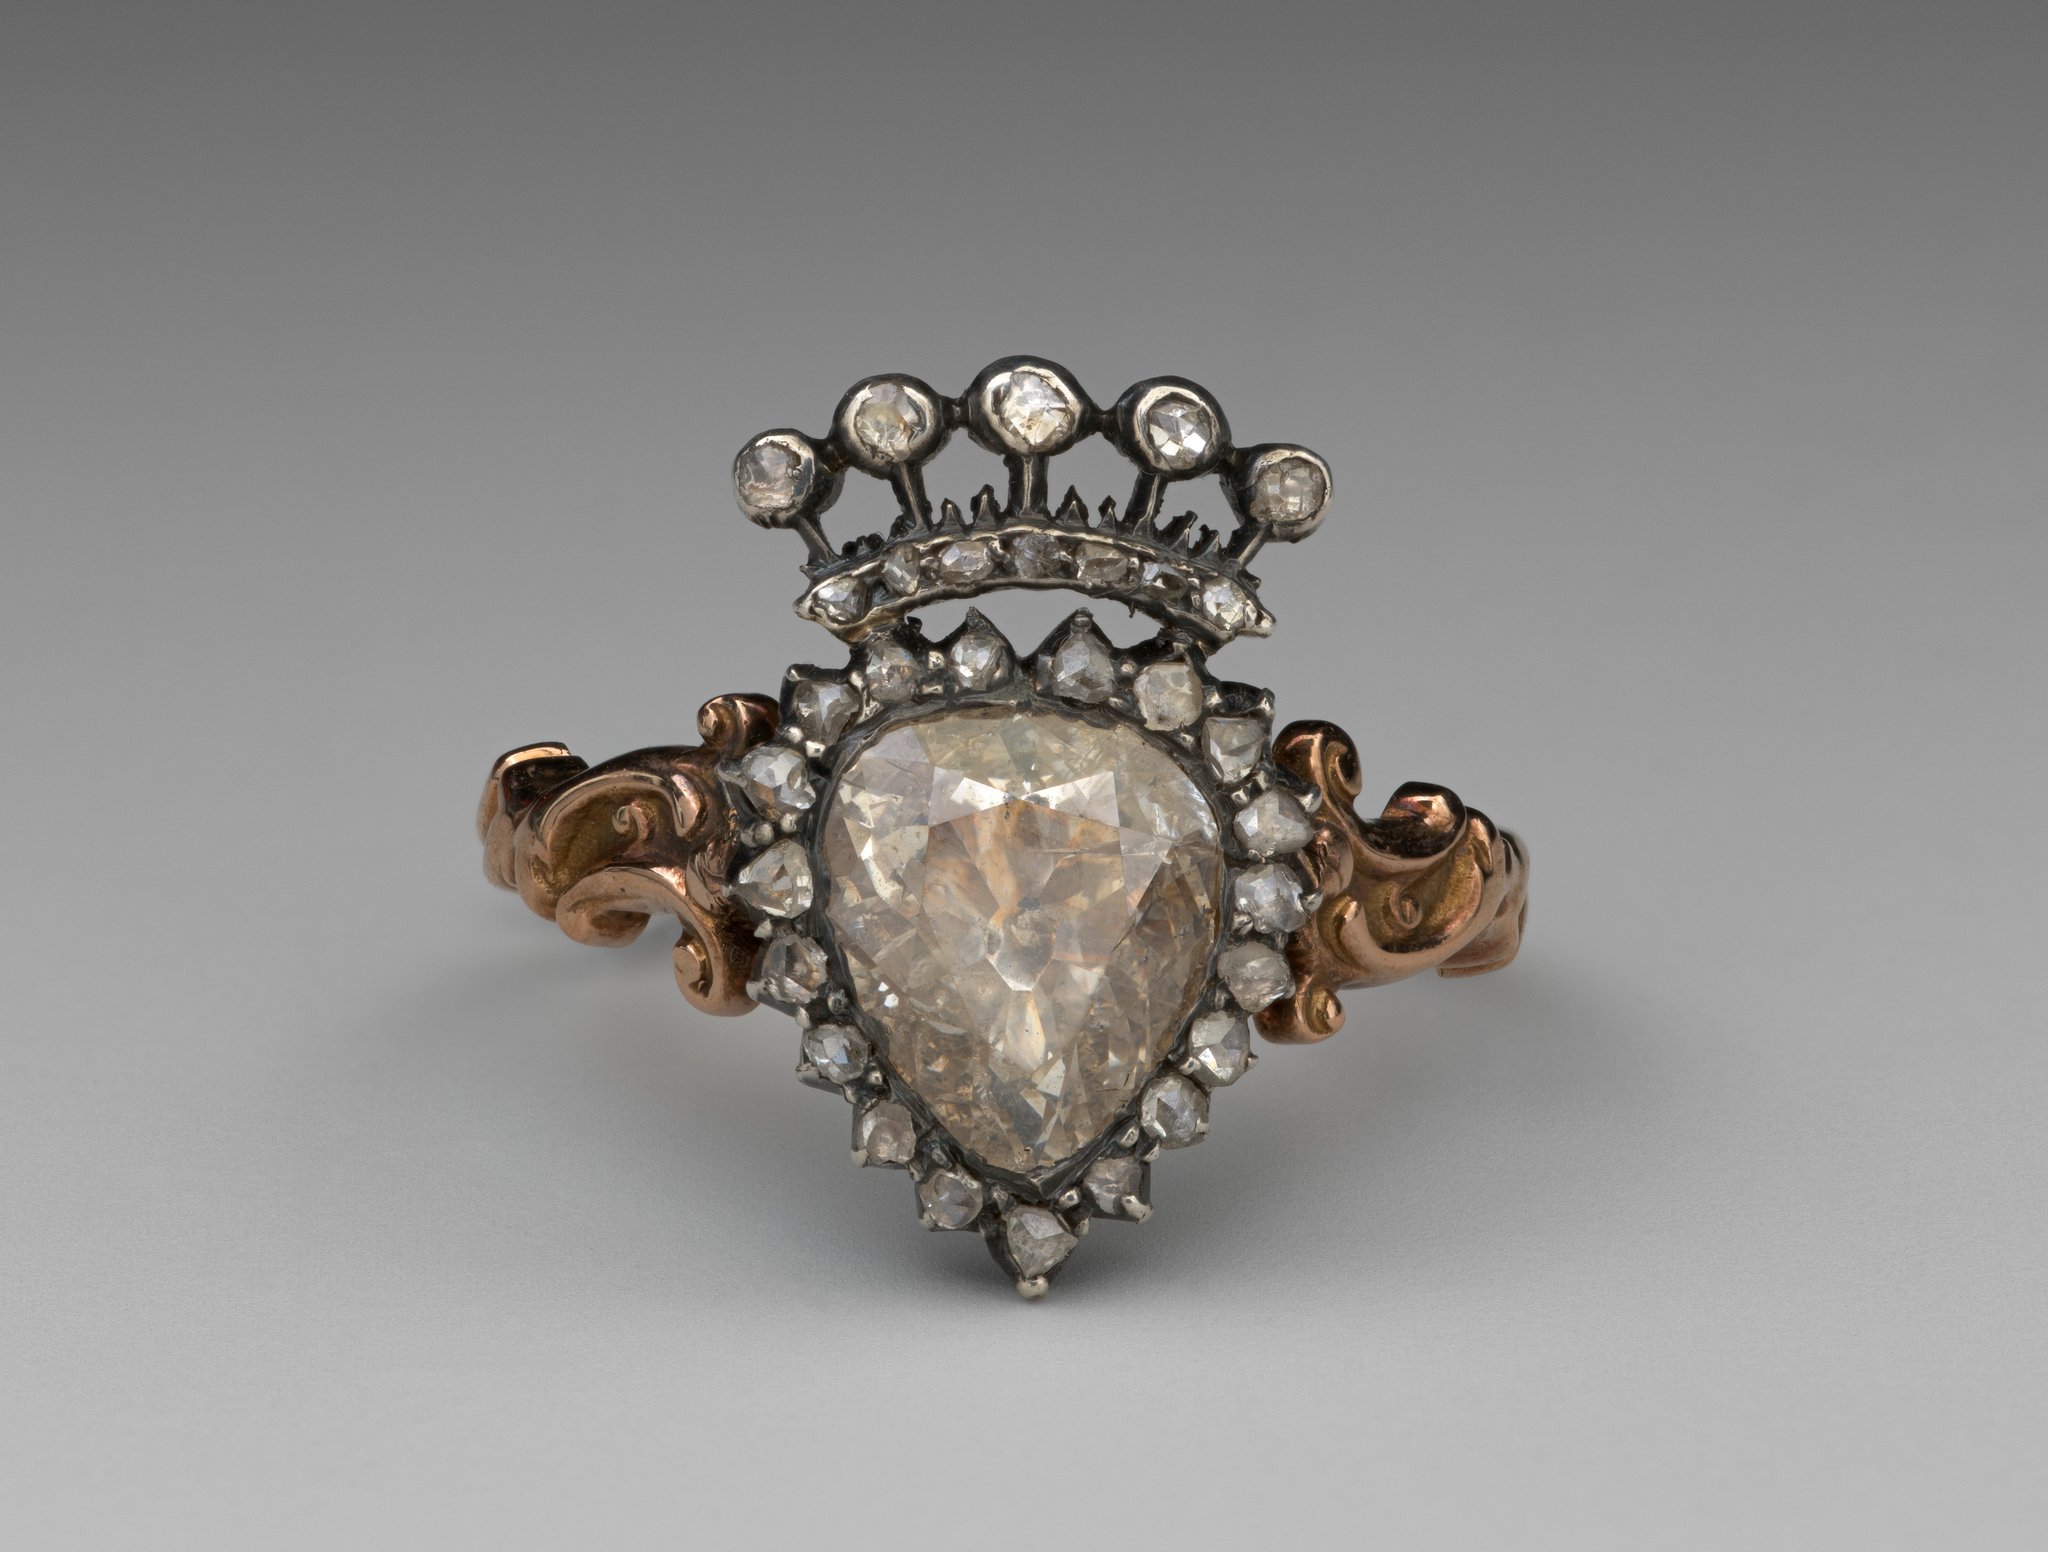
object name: ring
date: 1851-1900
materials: diamond, gold, silver